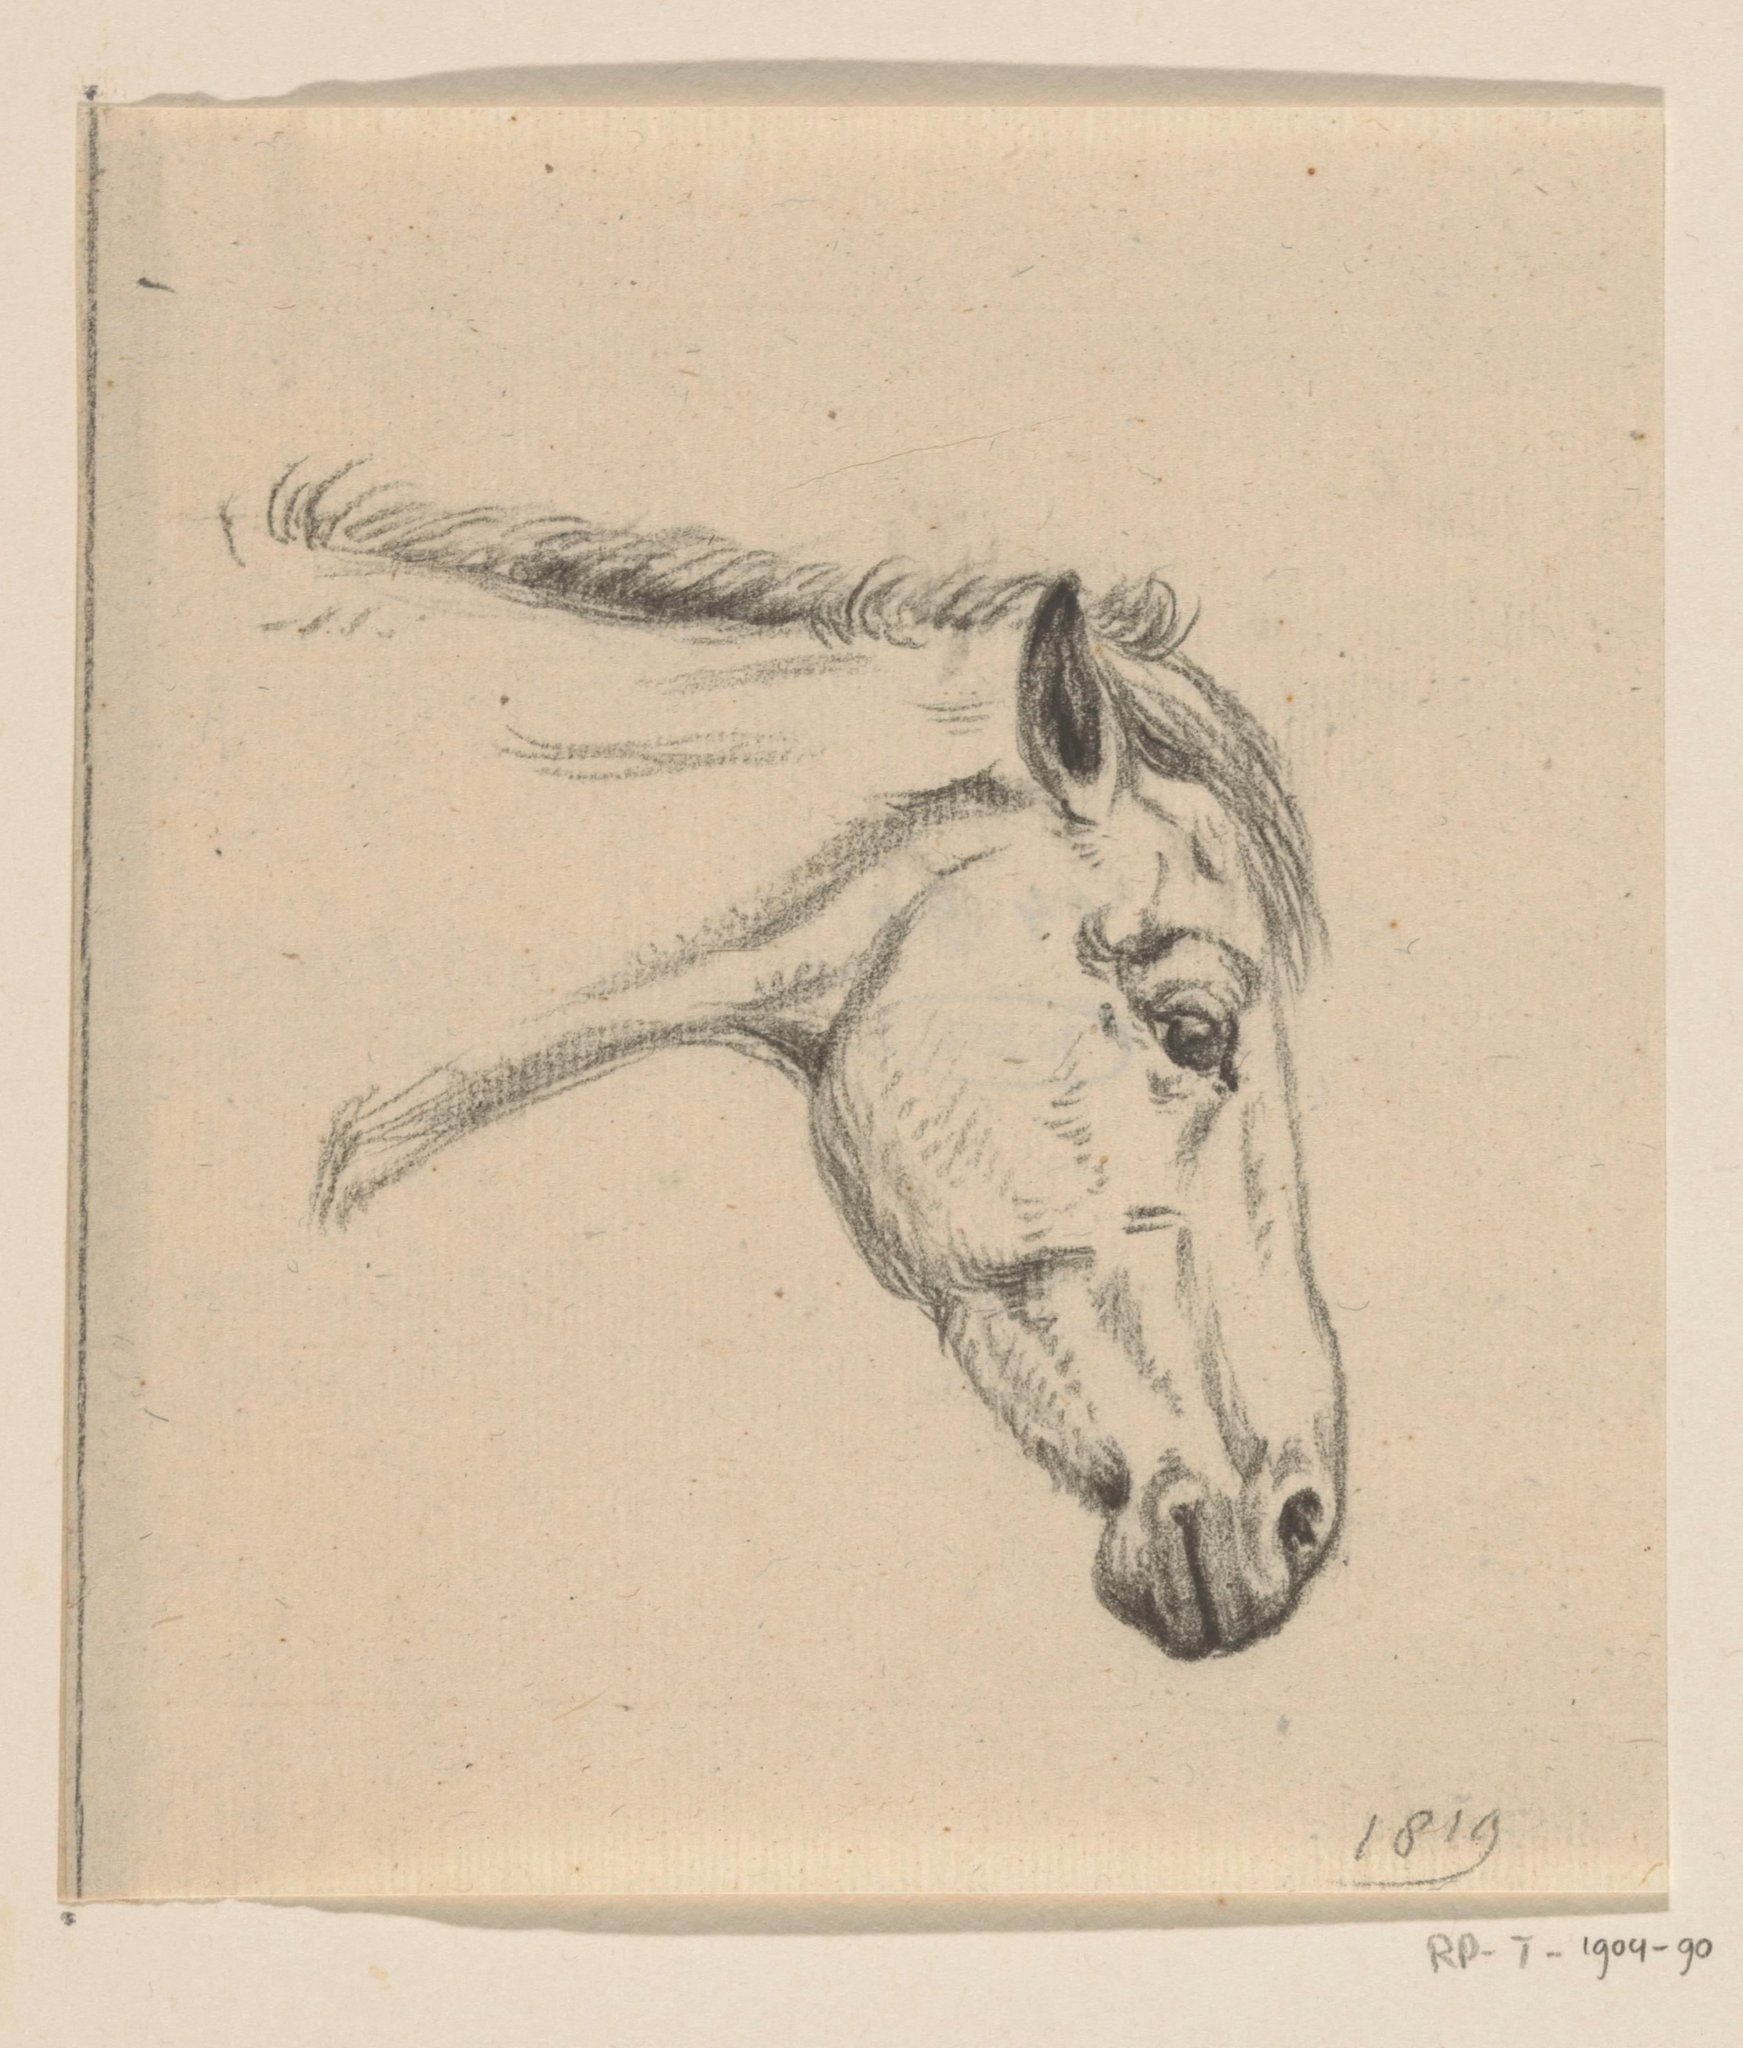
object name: drawing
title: Hoofd van een paard, naar rechts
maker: jean bernard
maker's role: draughtsman, print maker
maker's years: 1765-1833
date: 1819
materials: chalk, paper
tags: horse